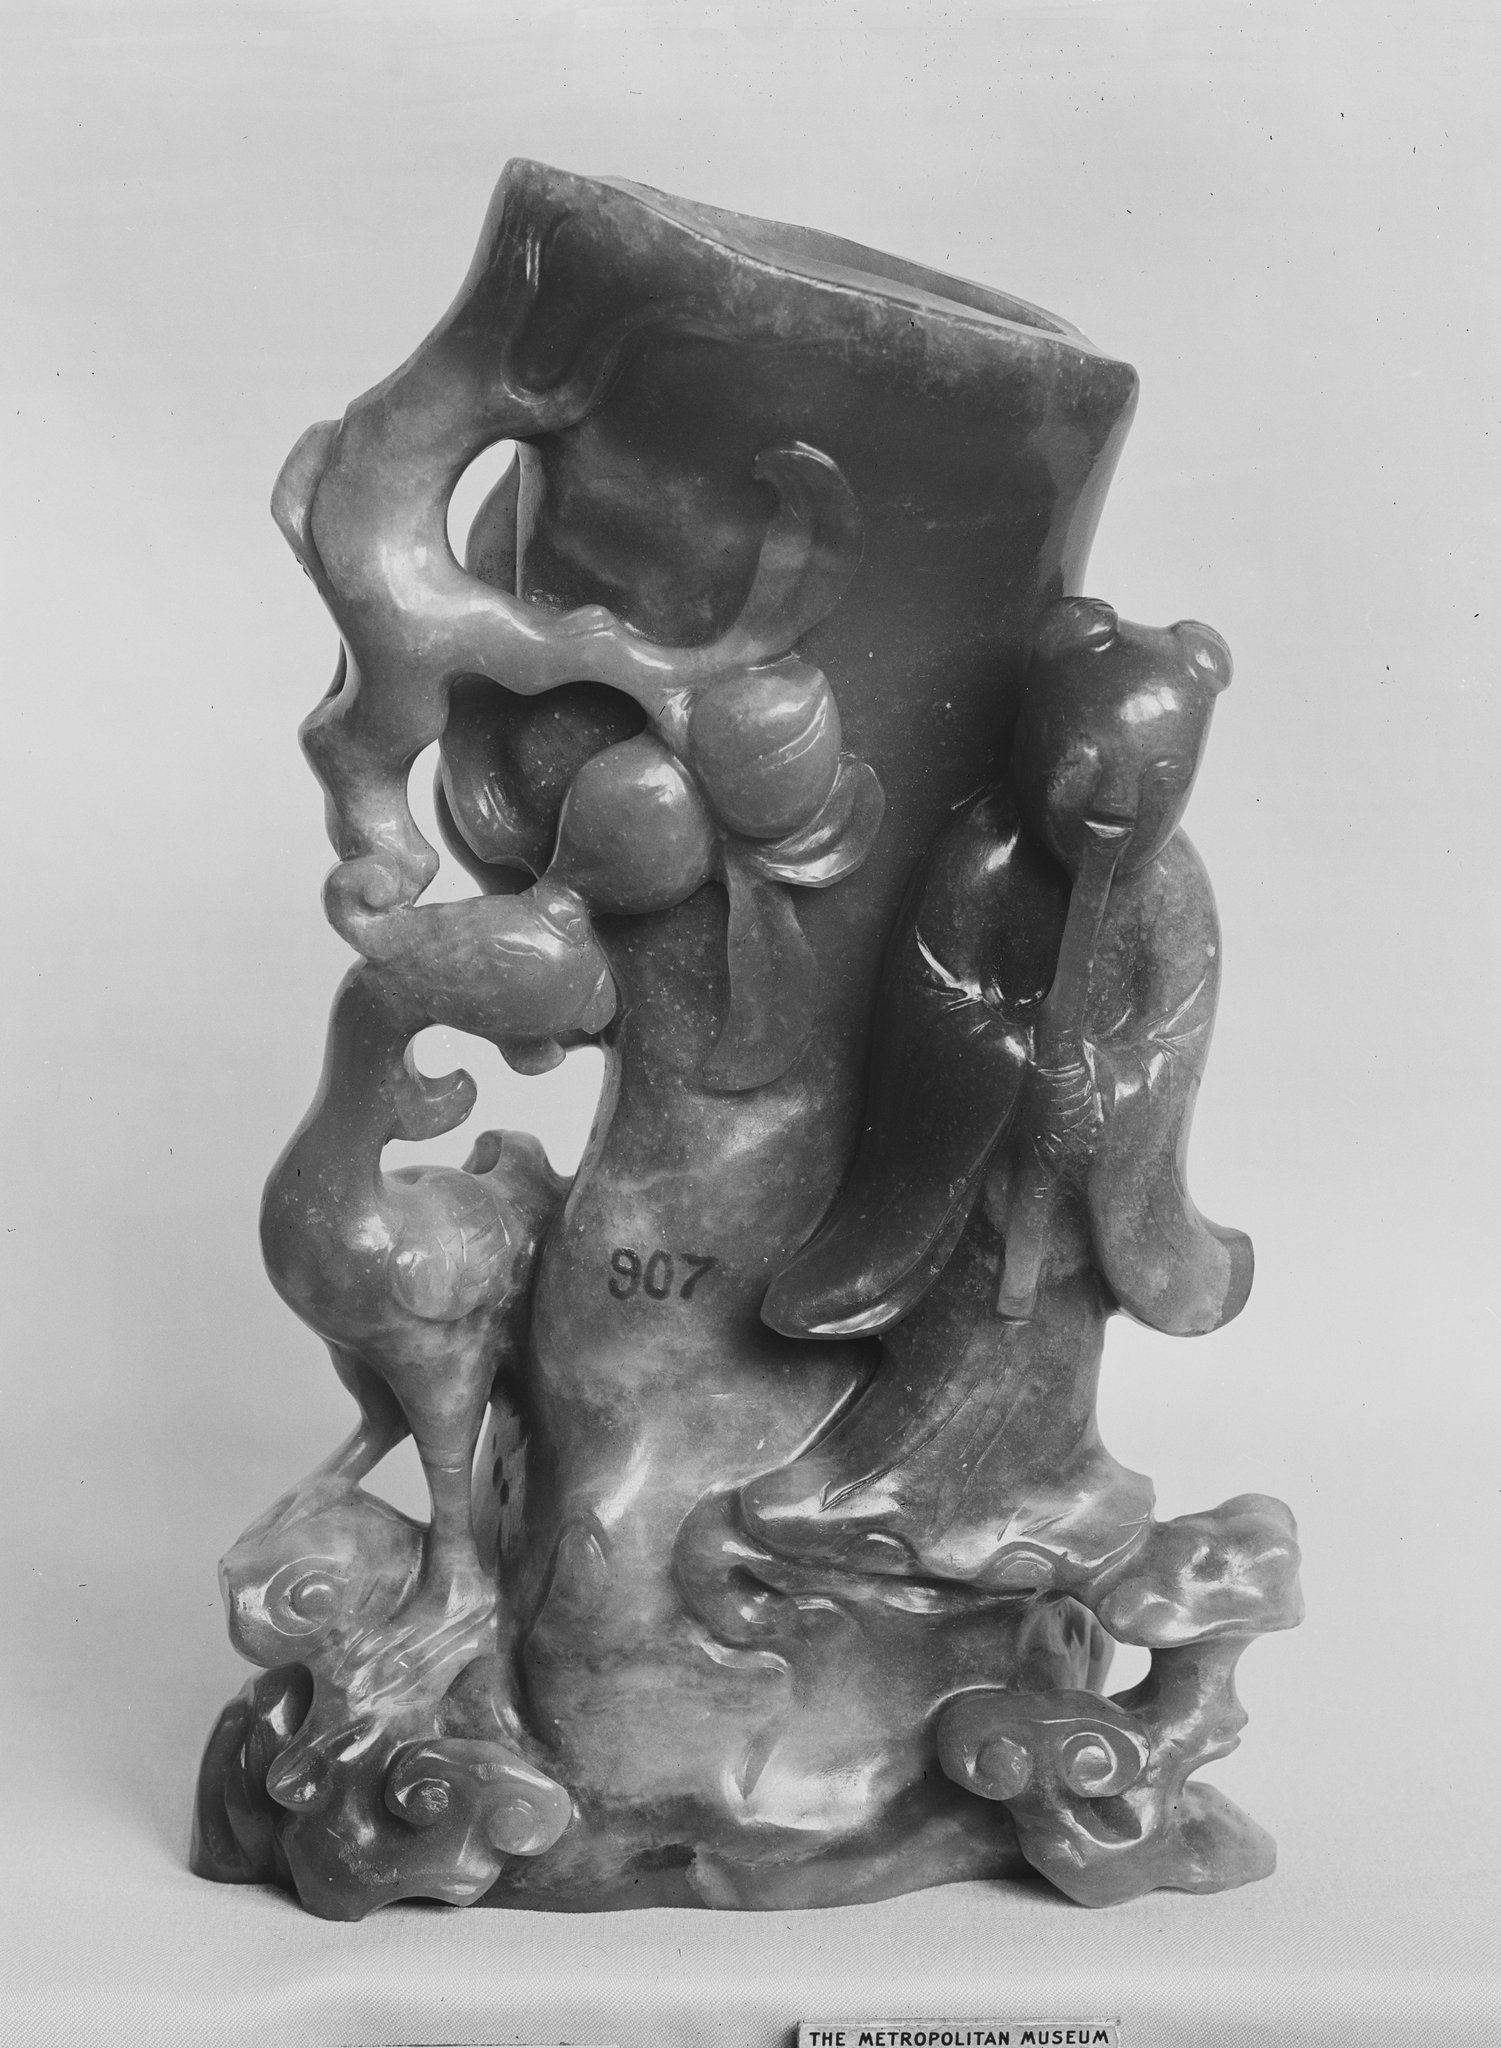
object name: vase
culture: chinese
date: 1701-1800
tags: men